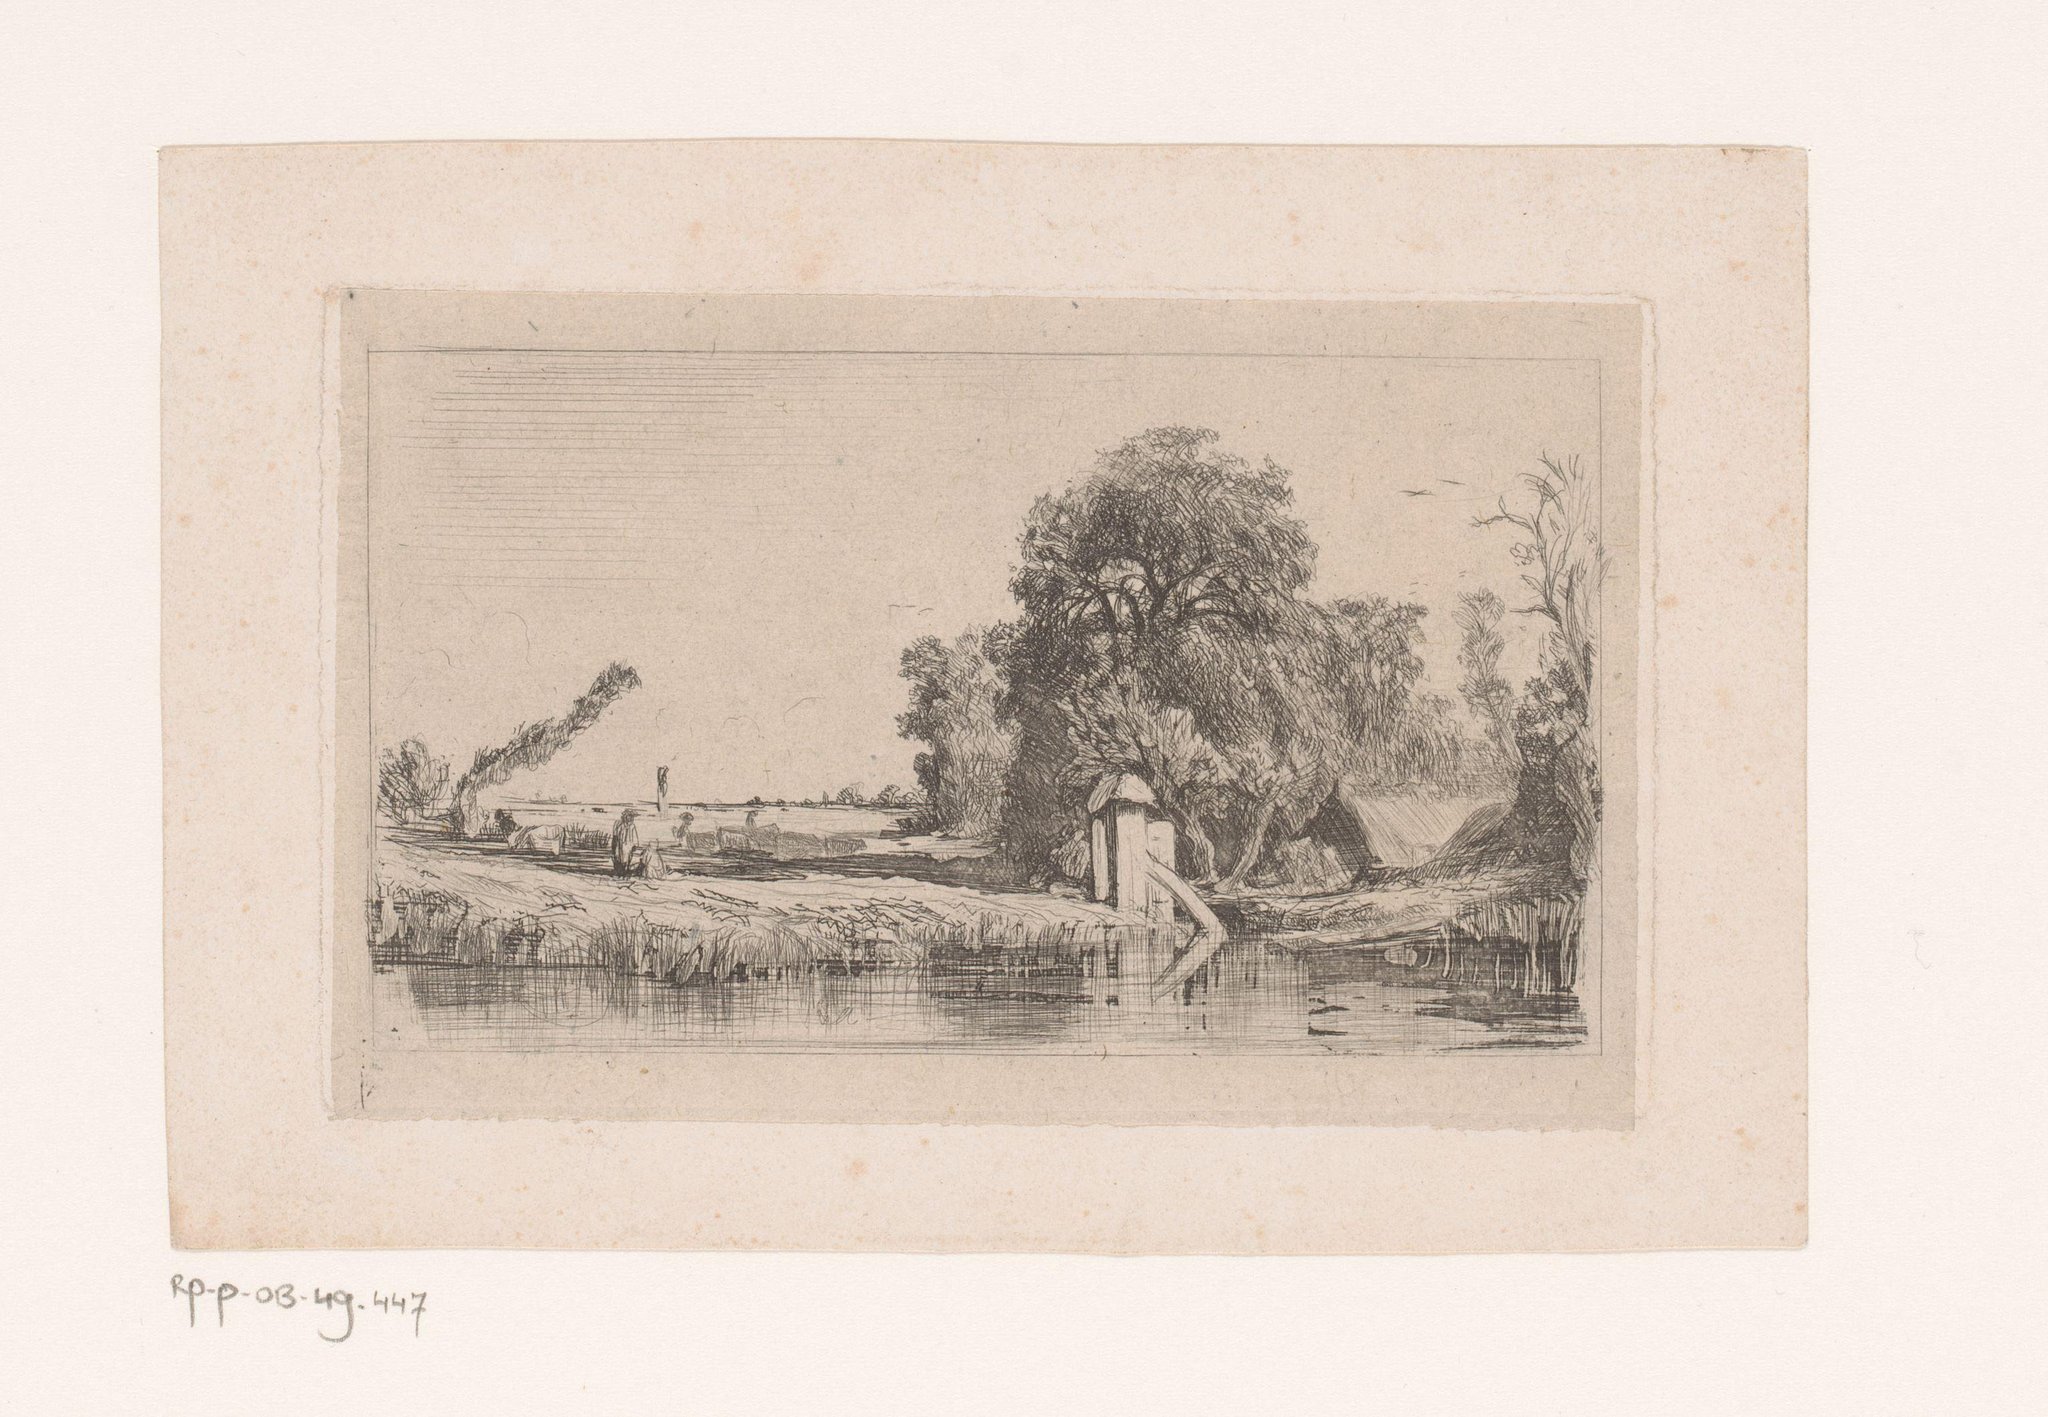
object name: print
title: Gezicht op waterkant met poort voor een bomenrij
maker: hendrik jozef franciscus van der poorten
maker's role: draughtsman, print maker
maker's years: 1789-1874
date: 1799-1874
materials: paper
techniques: etching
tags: river, gate, entrance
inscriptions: collector's mark: Lugt 2228